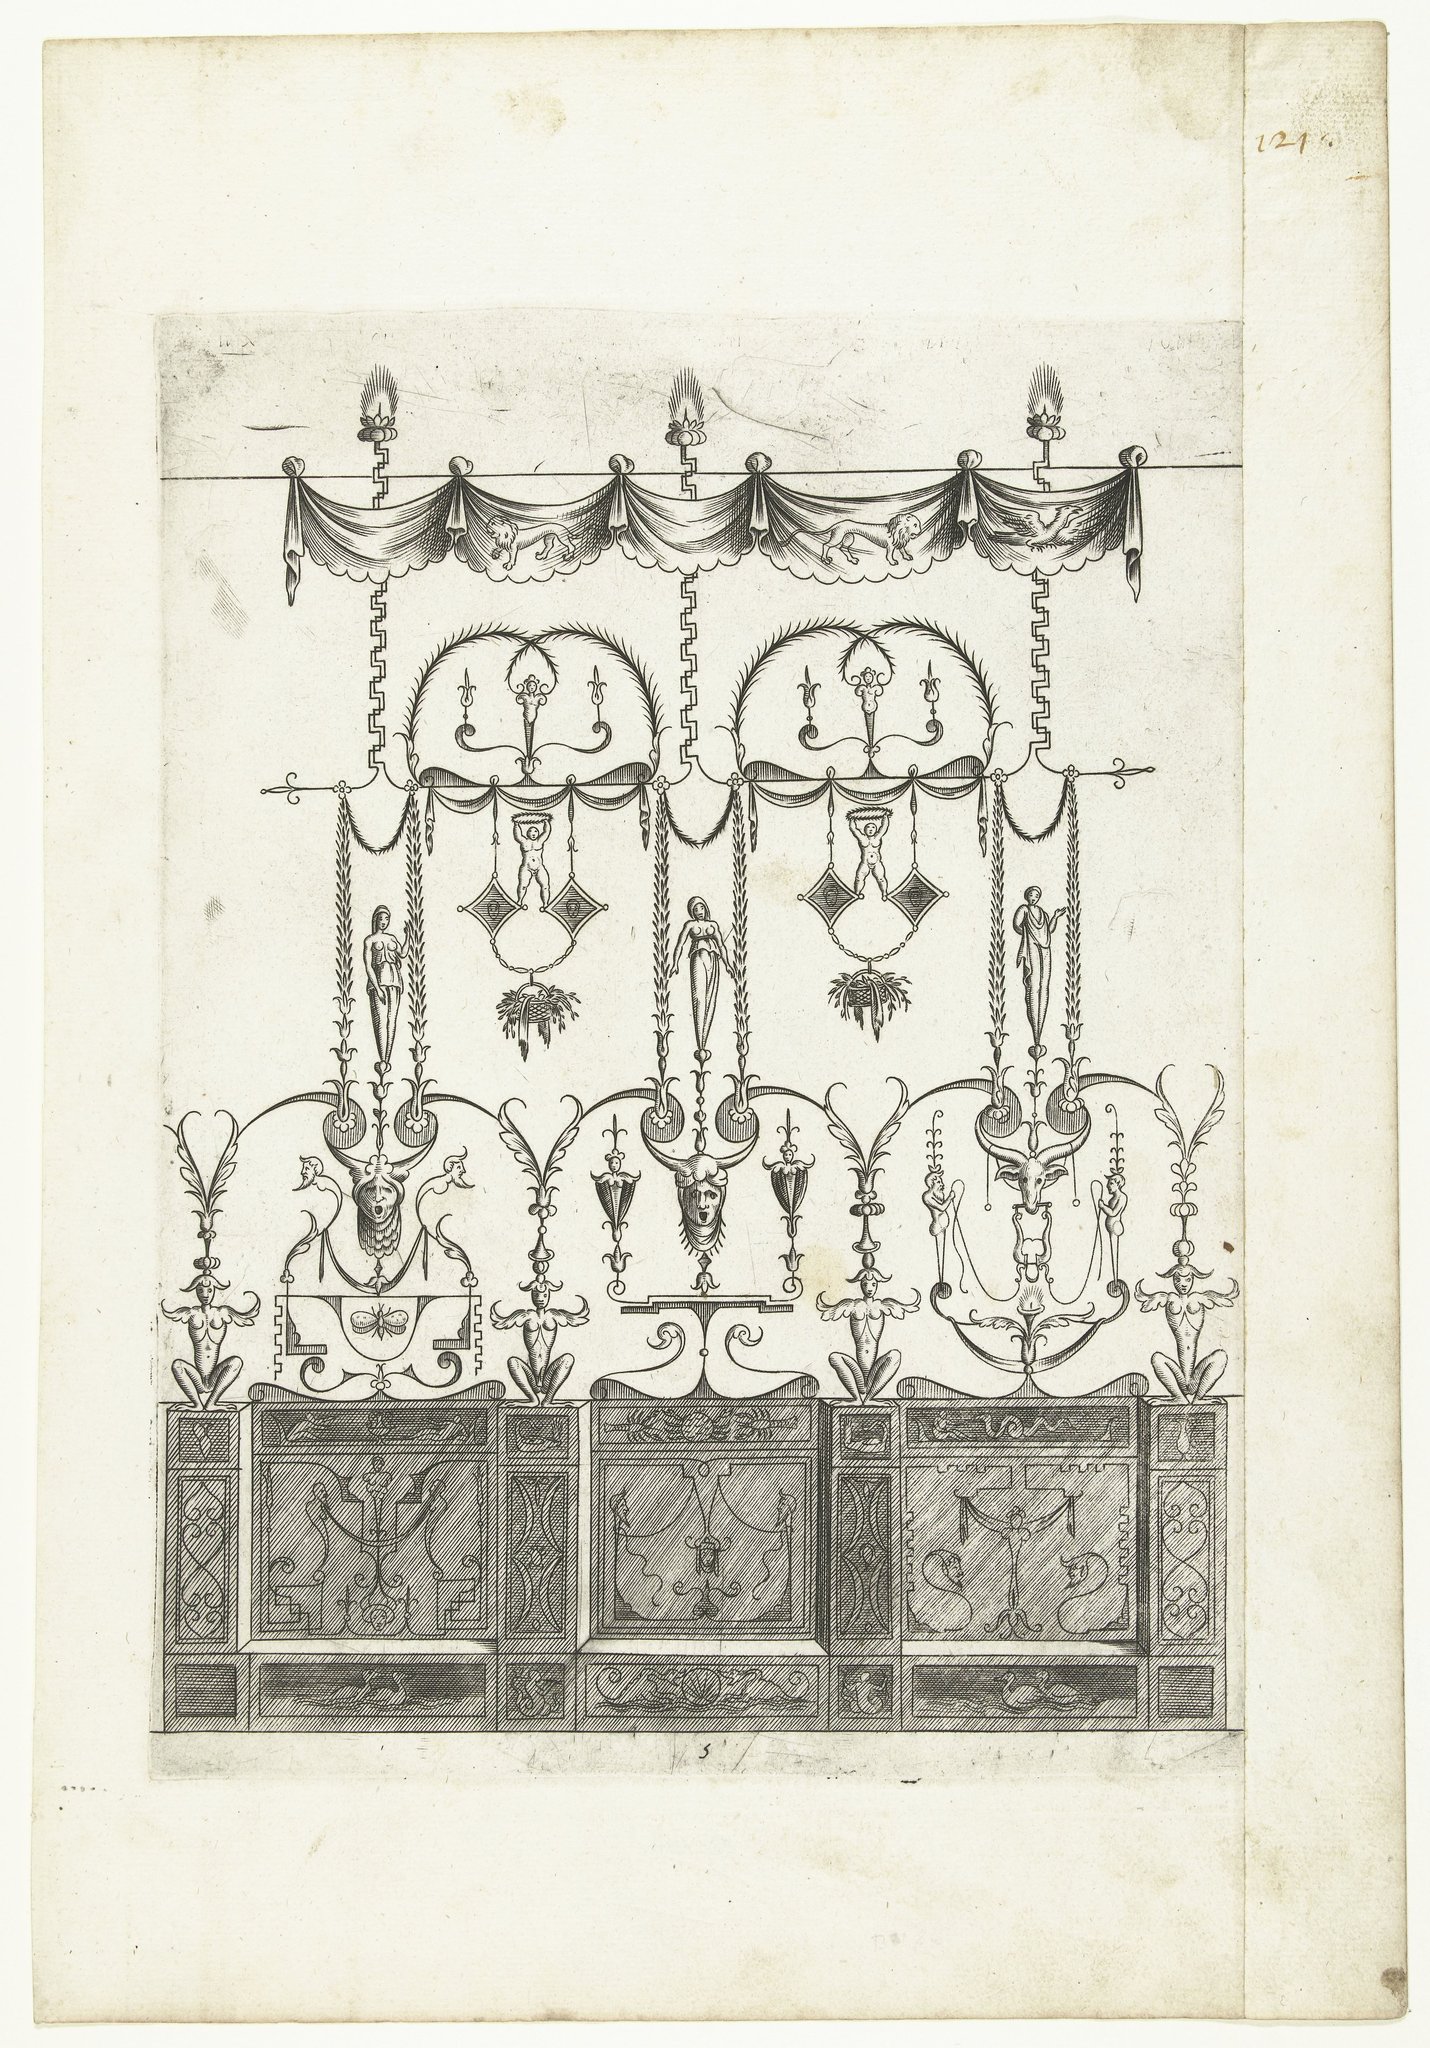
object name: ornament print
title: Architectuurfantasie met bovenaan een baldakijn met afbeeldingen van dieren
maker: Anonymous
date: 1530-1540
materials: paper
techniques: engraving, etching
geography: italy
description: Vlakdecoratie met grotesken. Uit serie van 20 bladen.